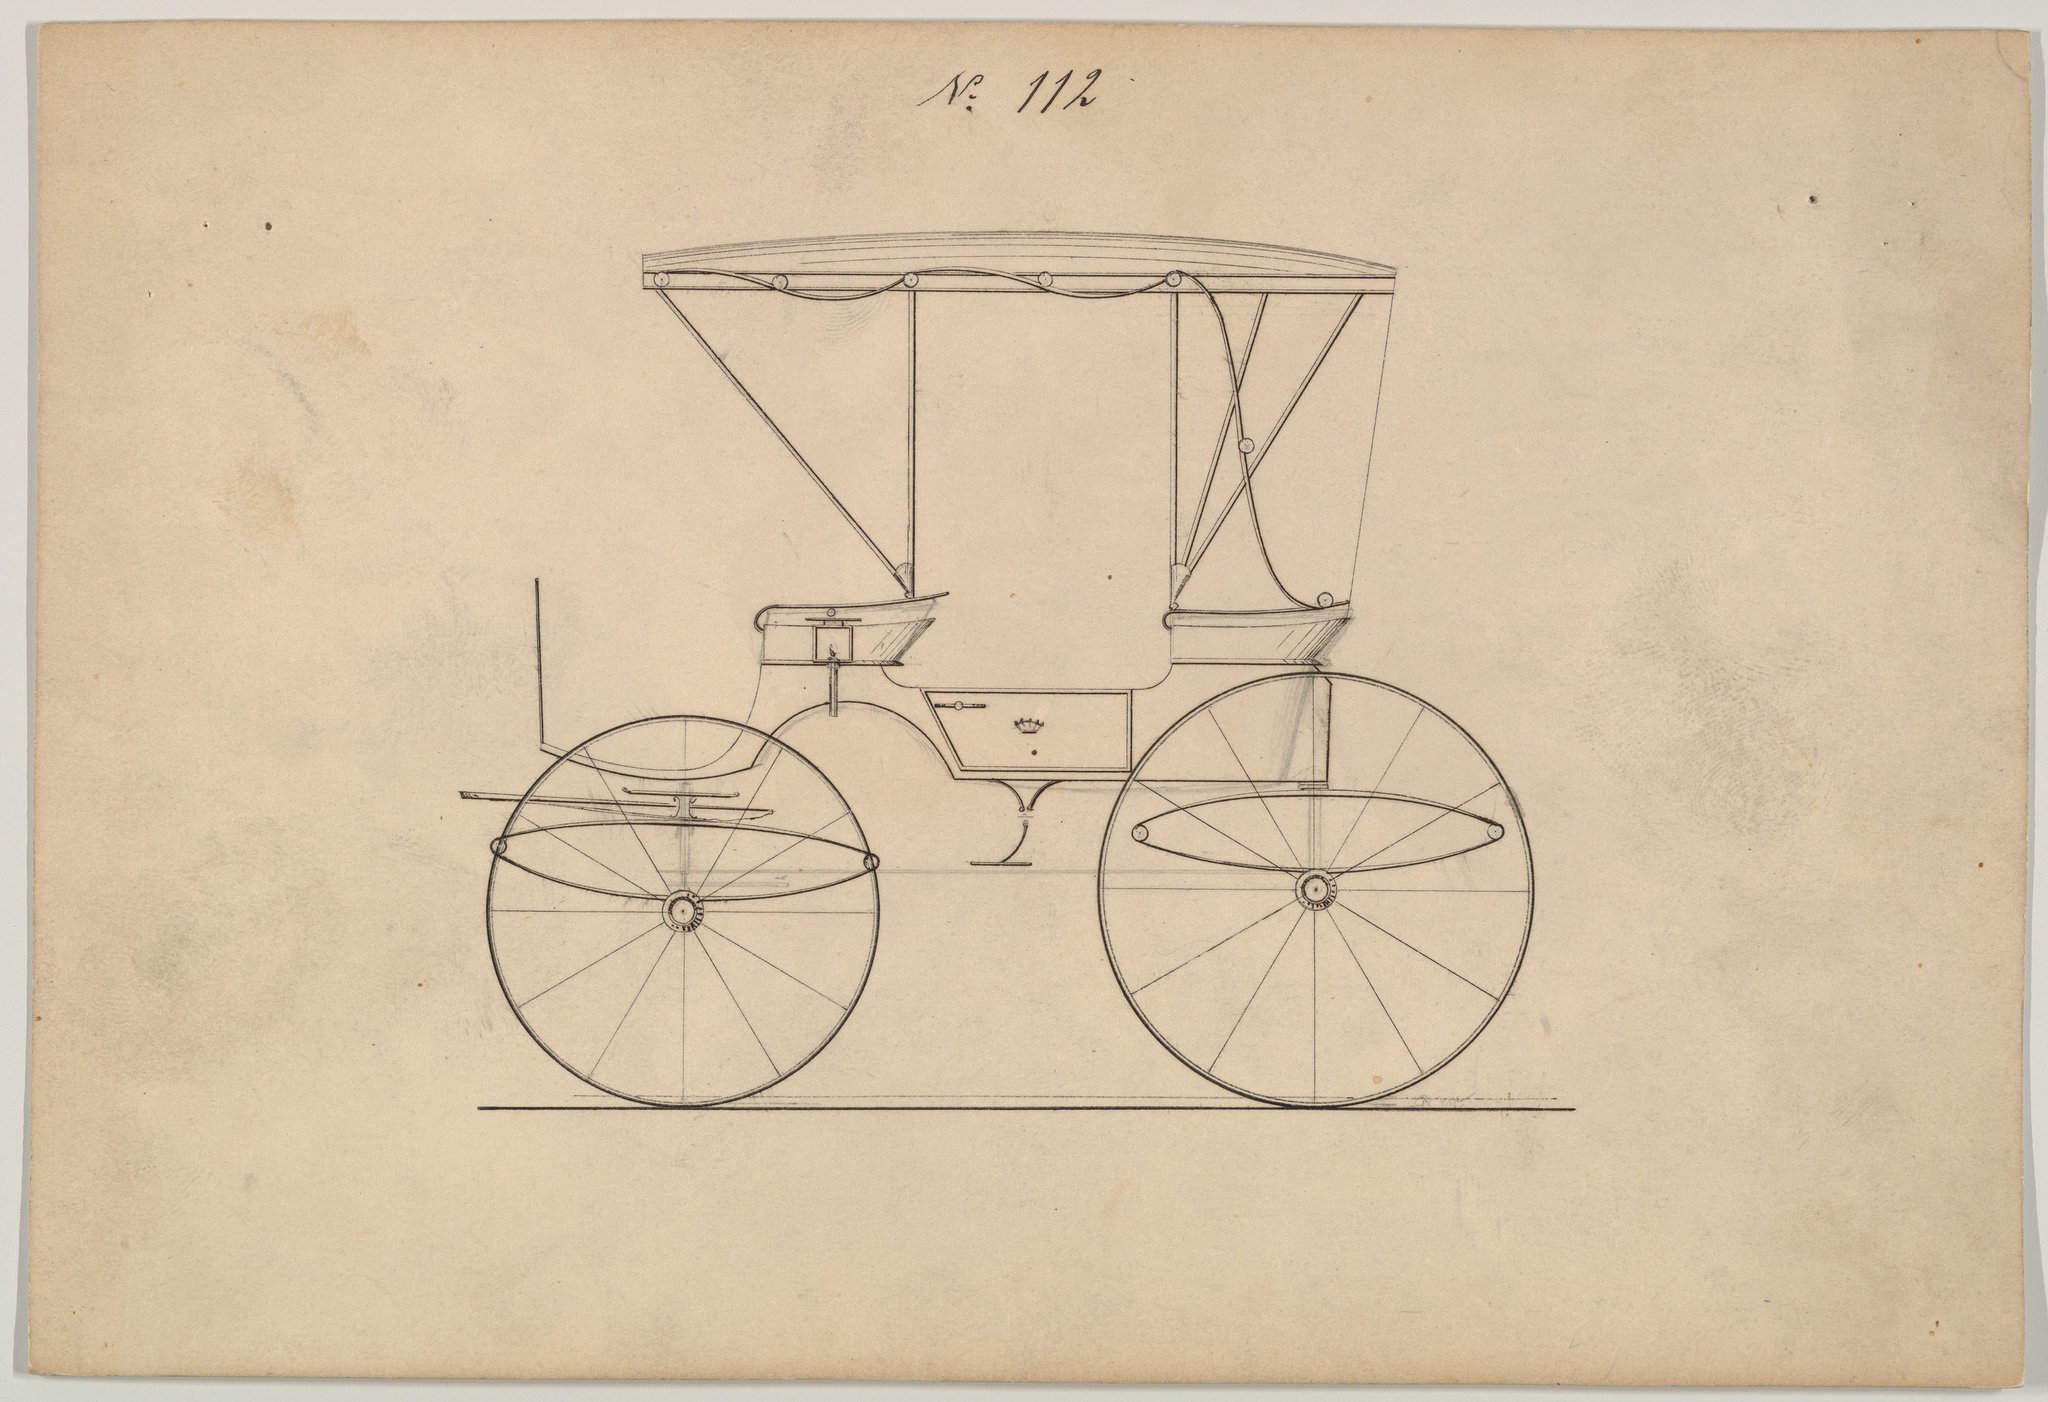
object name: drawing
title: Design for Park Phaeton, no. 112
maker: brewster & co.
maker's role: manufacturer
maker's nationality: american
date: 1850-1874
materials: graphite, ink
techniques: pen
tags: carriages